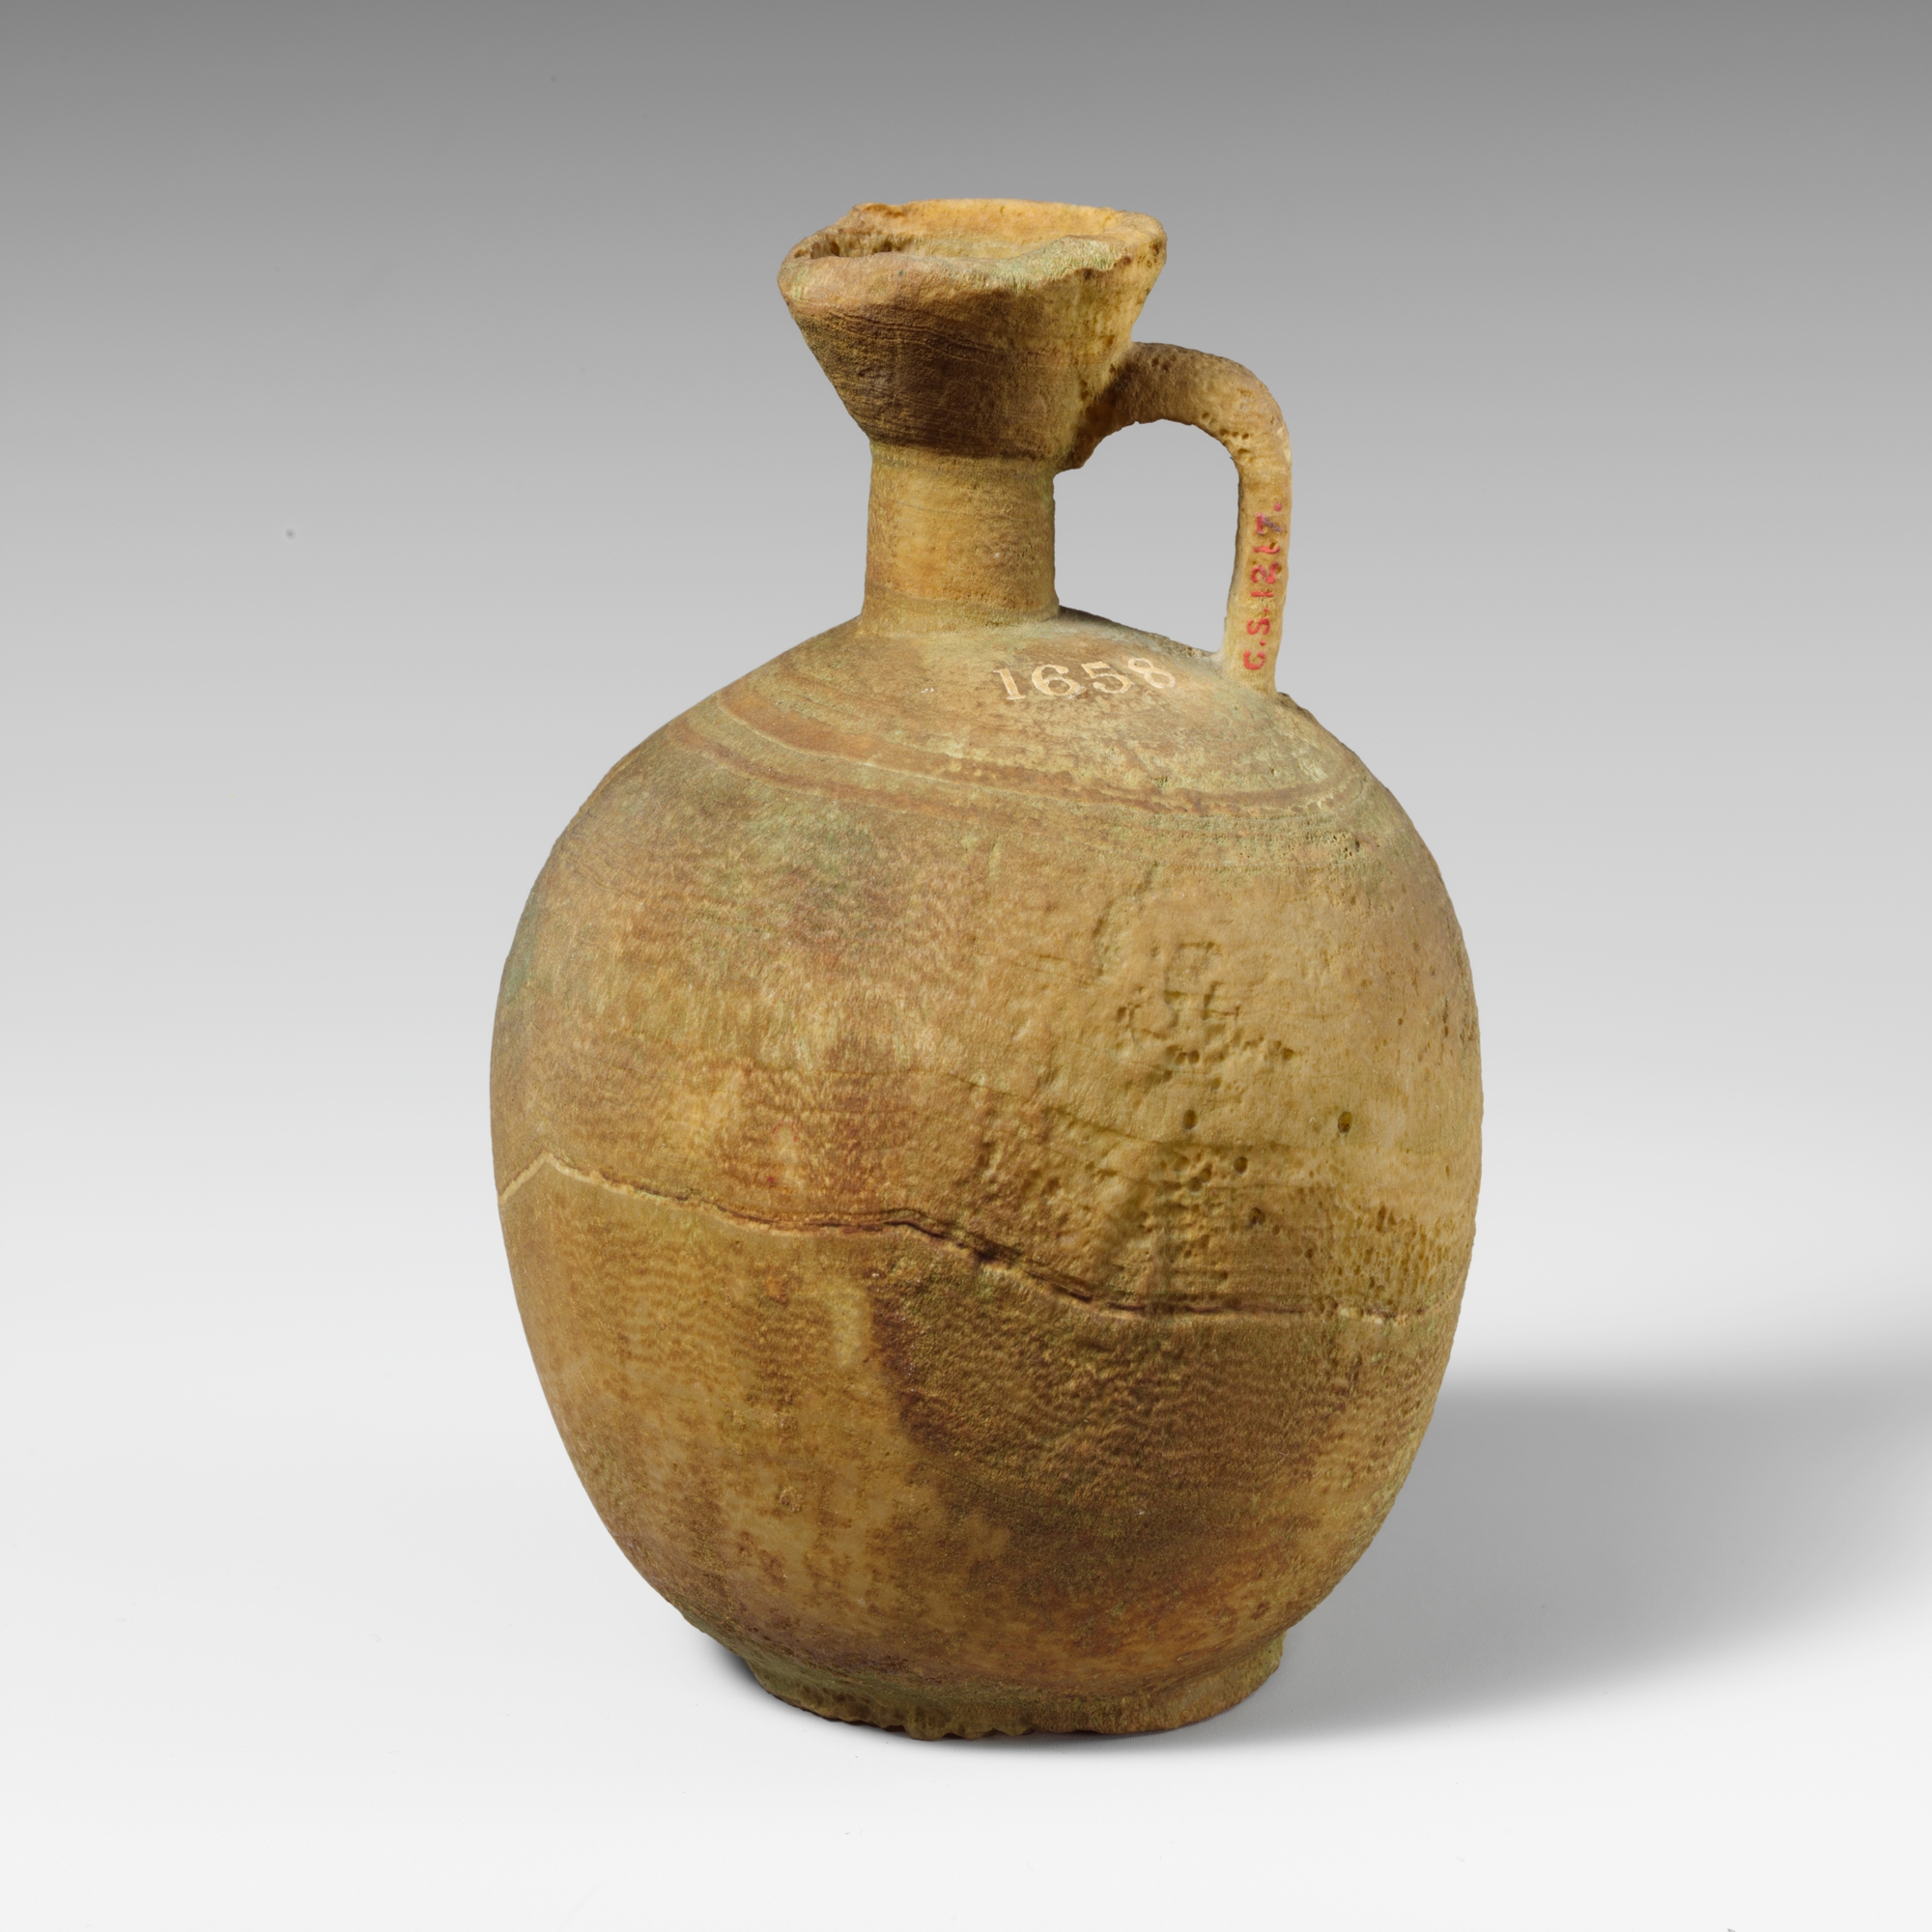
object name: vase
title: Alabaster squat lekythos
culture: cypriot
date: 500-201 BCE